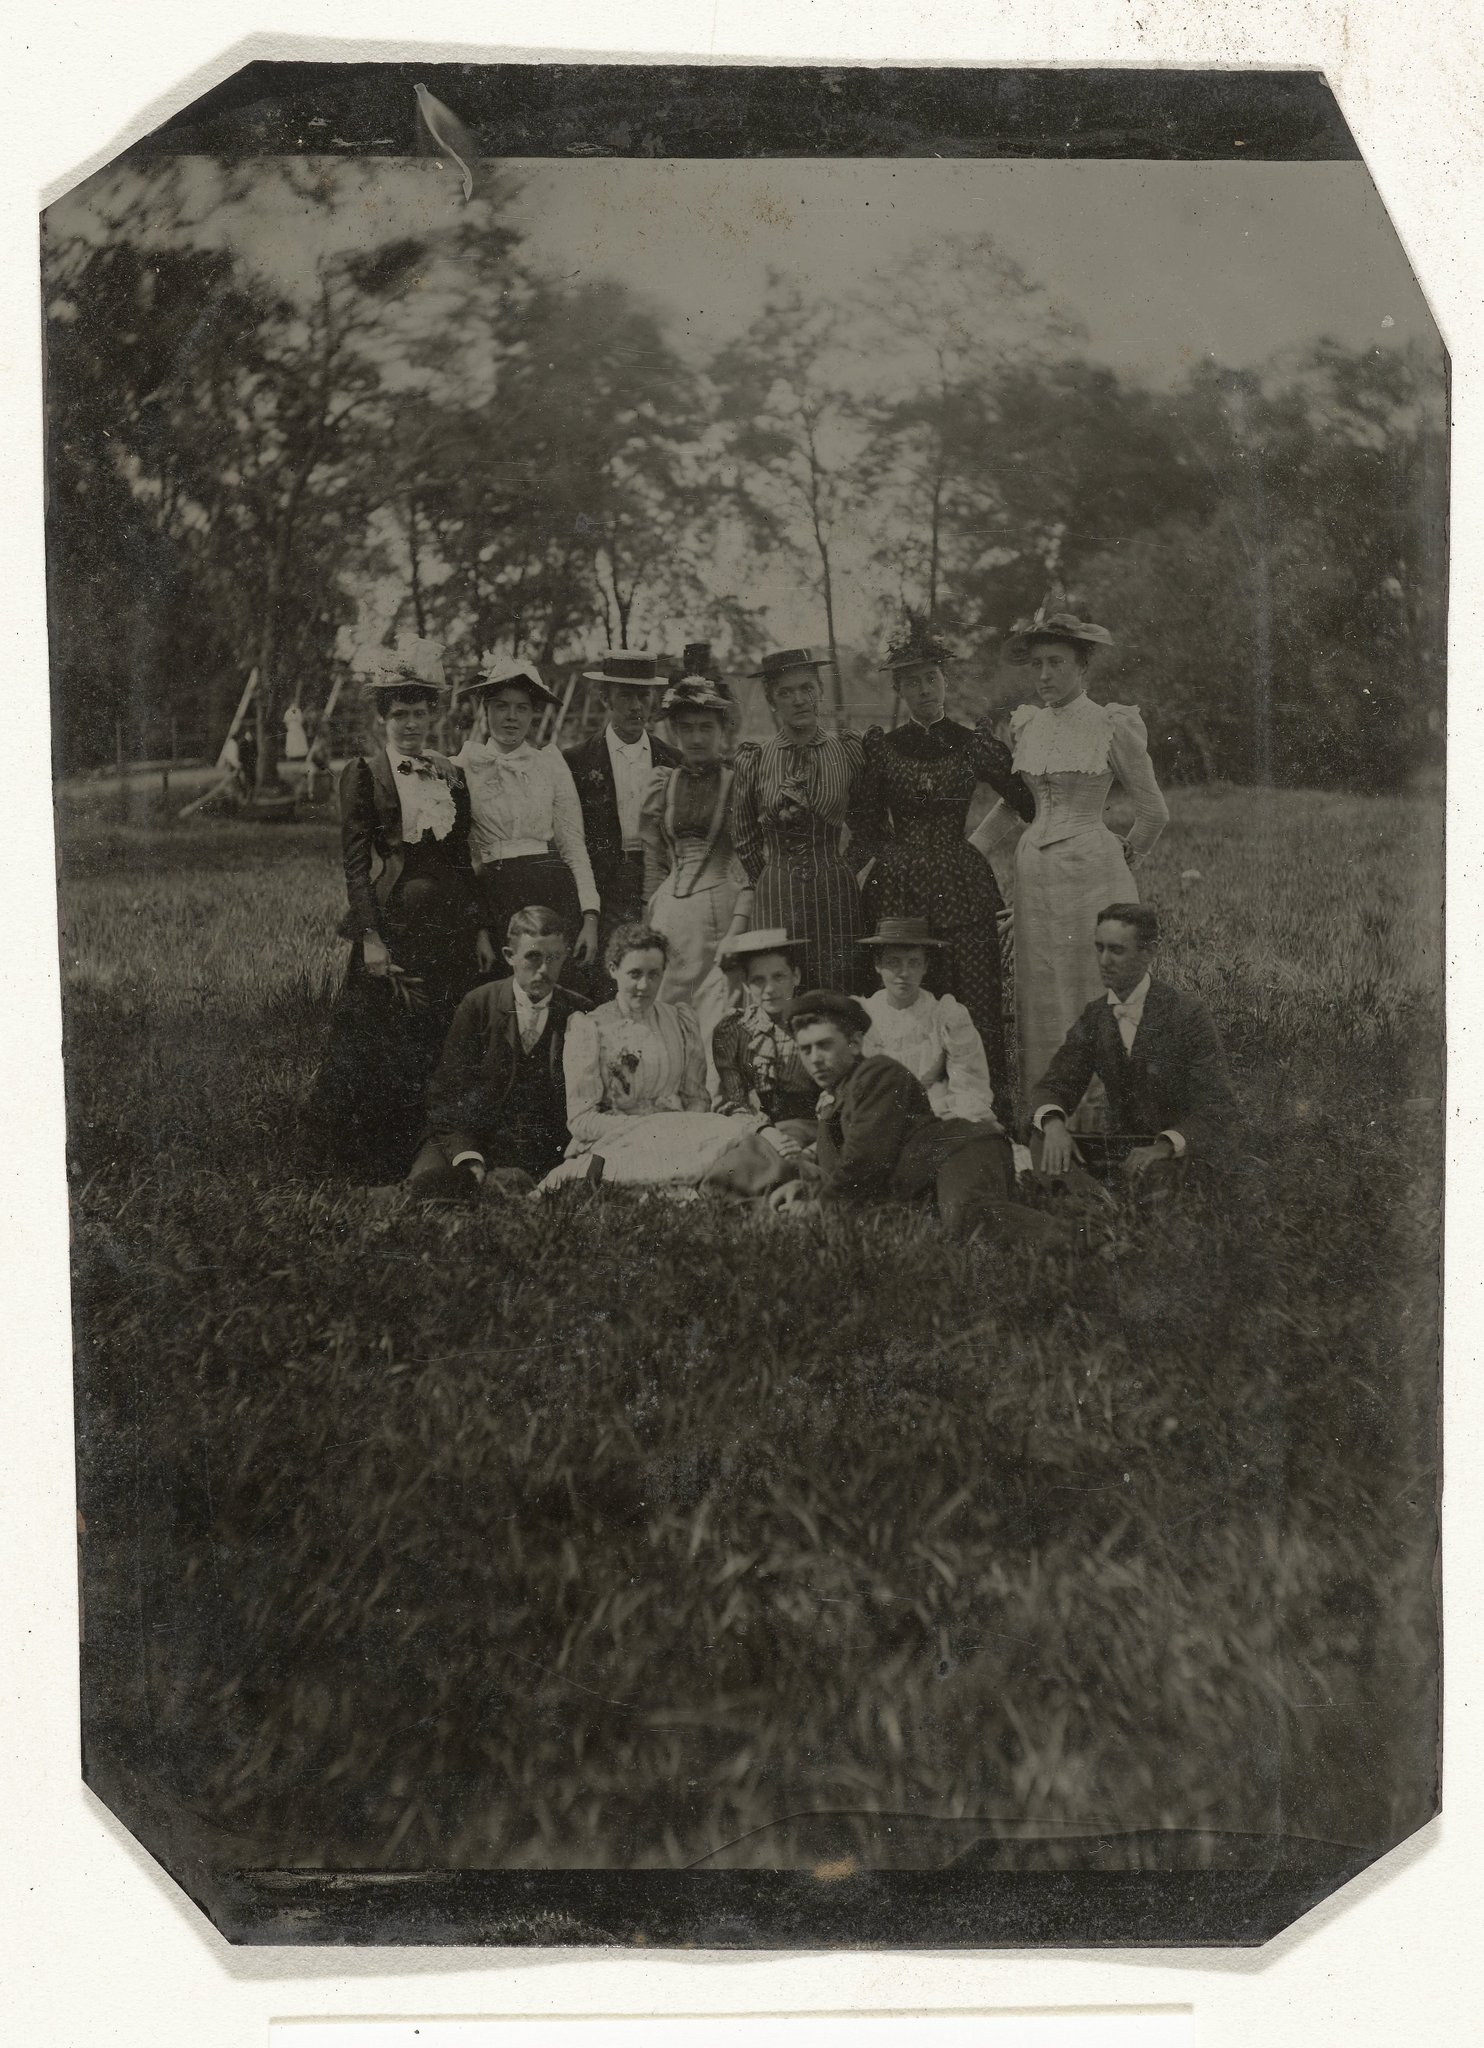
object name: photograph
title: Groepsportret van negen vrouwen (onder wie Estelle Hopping) en vier mannen staand en zittend in het gras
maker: Anonymous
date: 1892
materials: metal, paper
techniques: ferrotyping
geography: united states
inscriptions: annotation: ‘Sept.6.1892 / Estelle Hopping / standing extreme right’